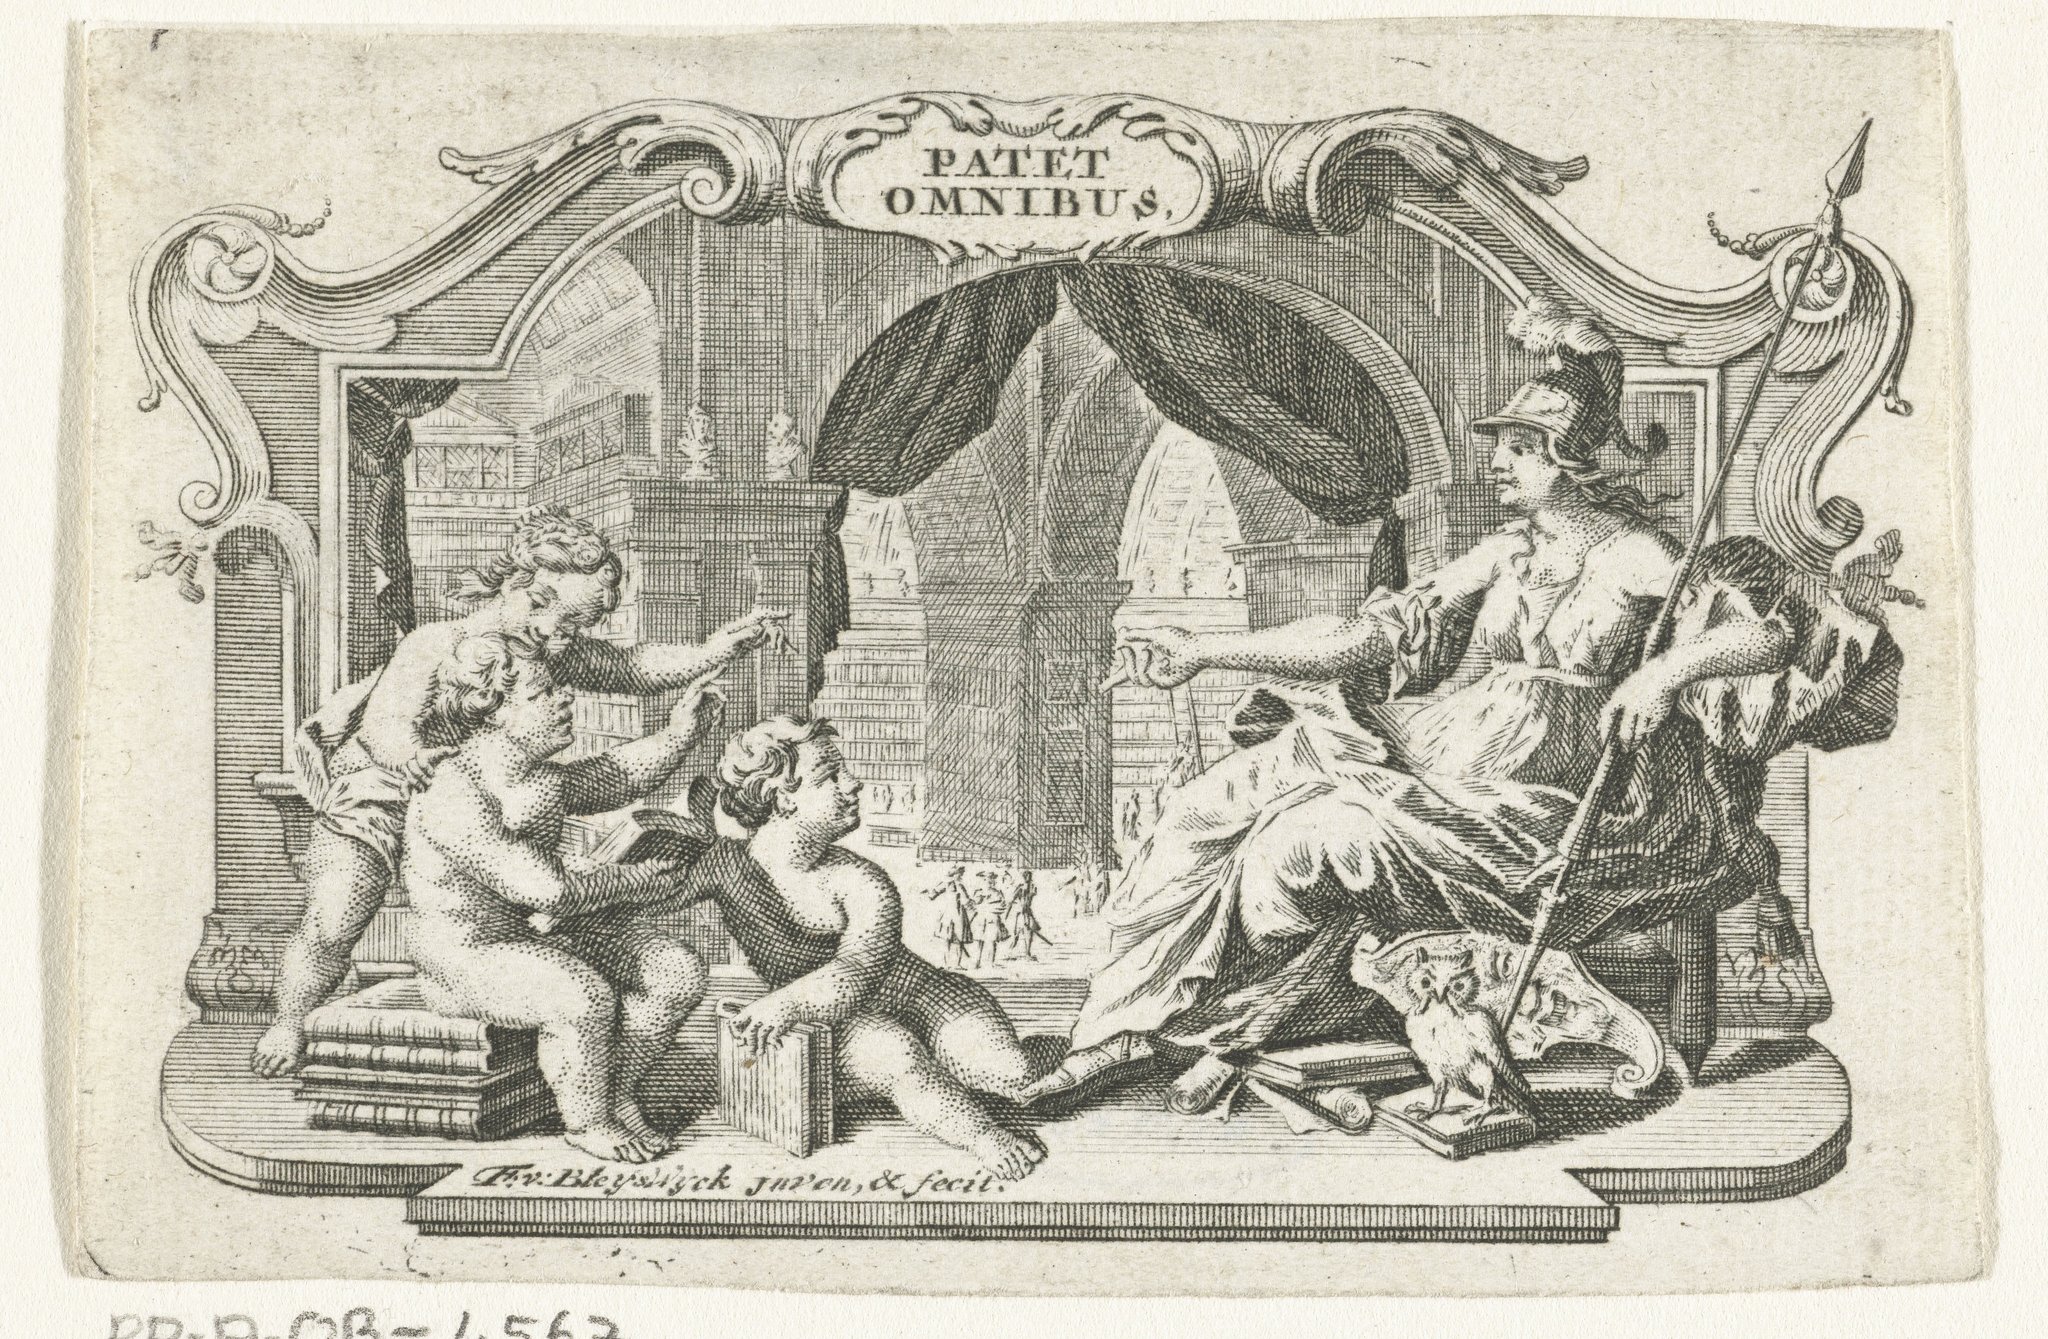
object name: print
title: Titelvignet met bibliotheek en godin Minerva en putti met boeken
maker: françois van bleyswijck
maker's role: draughtsman, print maker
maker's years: 1671-1746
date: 1681-1746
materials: paper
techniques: engraving, etching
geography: leiden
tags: (story of) minerva (pallas, athena), book, vignette, public library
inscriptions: collector's mark: Lugt 2228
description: Titelvignet met interieur van grote bibliotheek in omlijsting met krulornamenten. Voor de lijst troont godin Minerva met putti die boeken raadplegen.